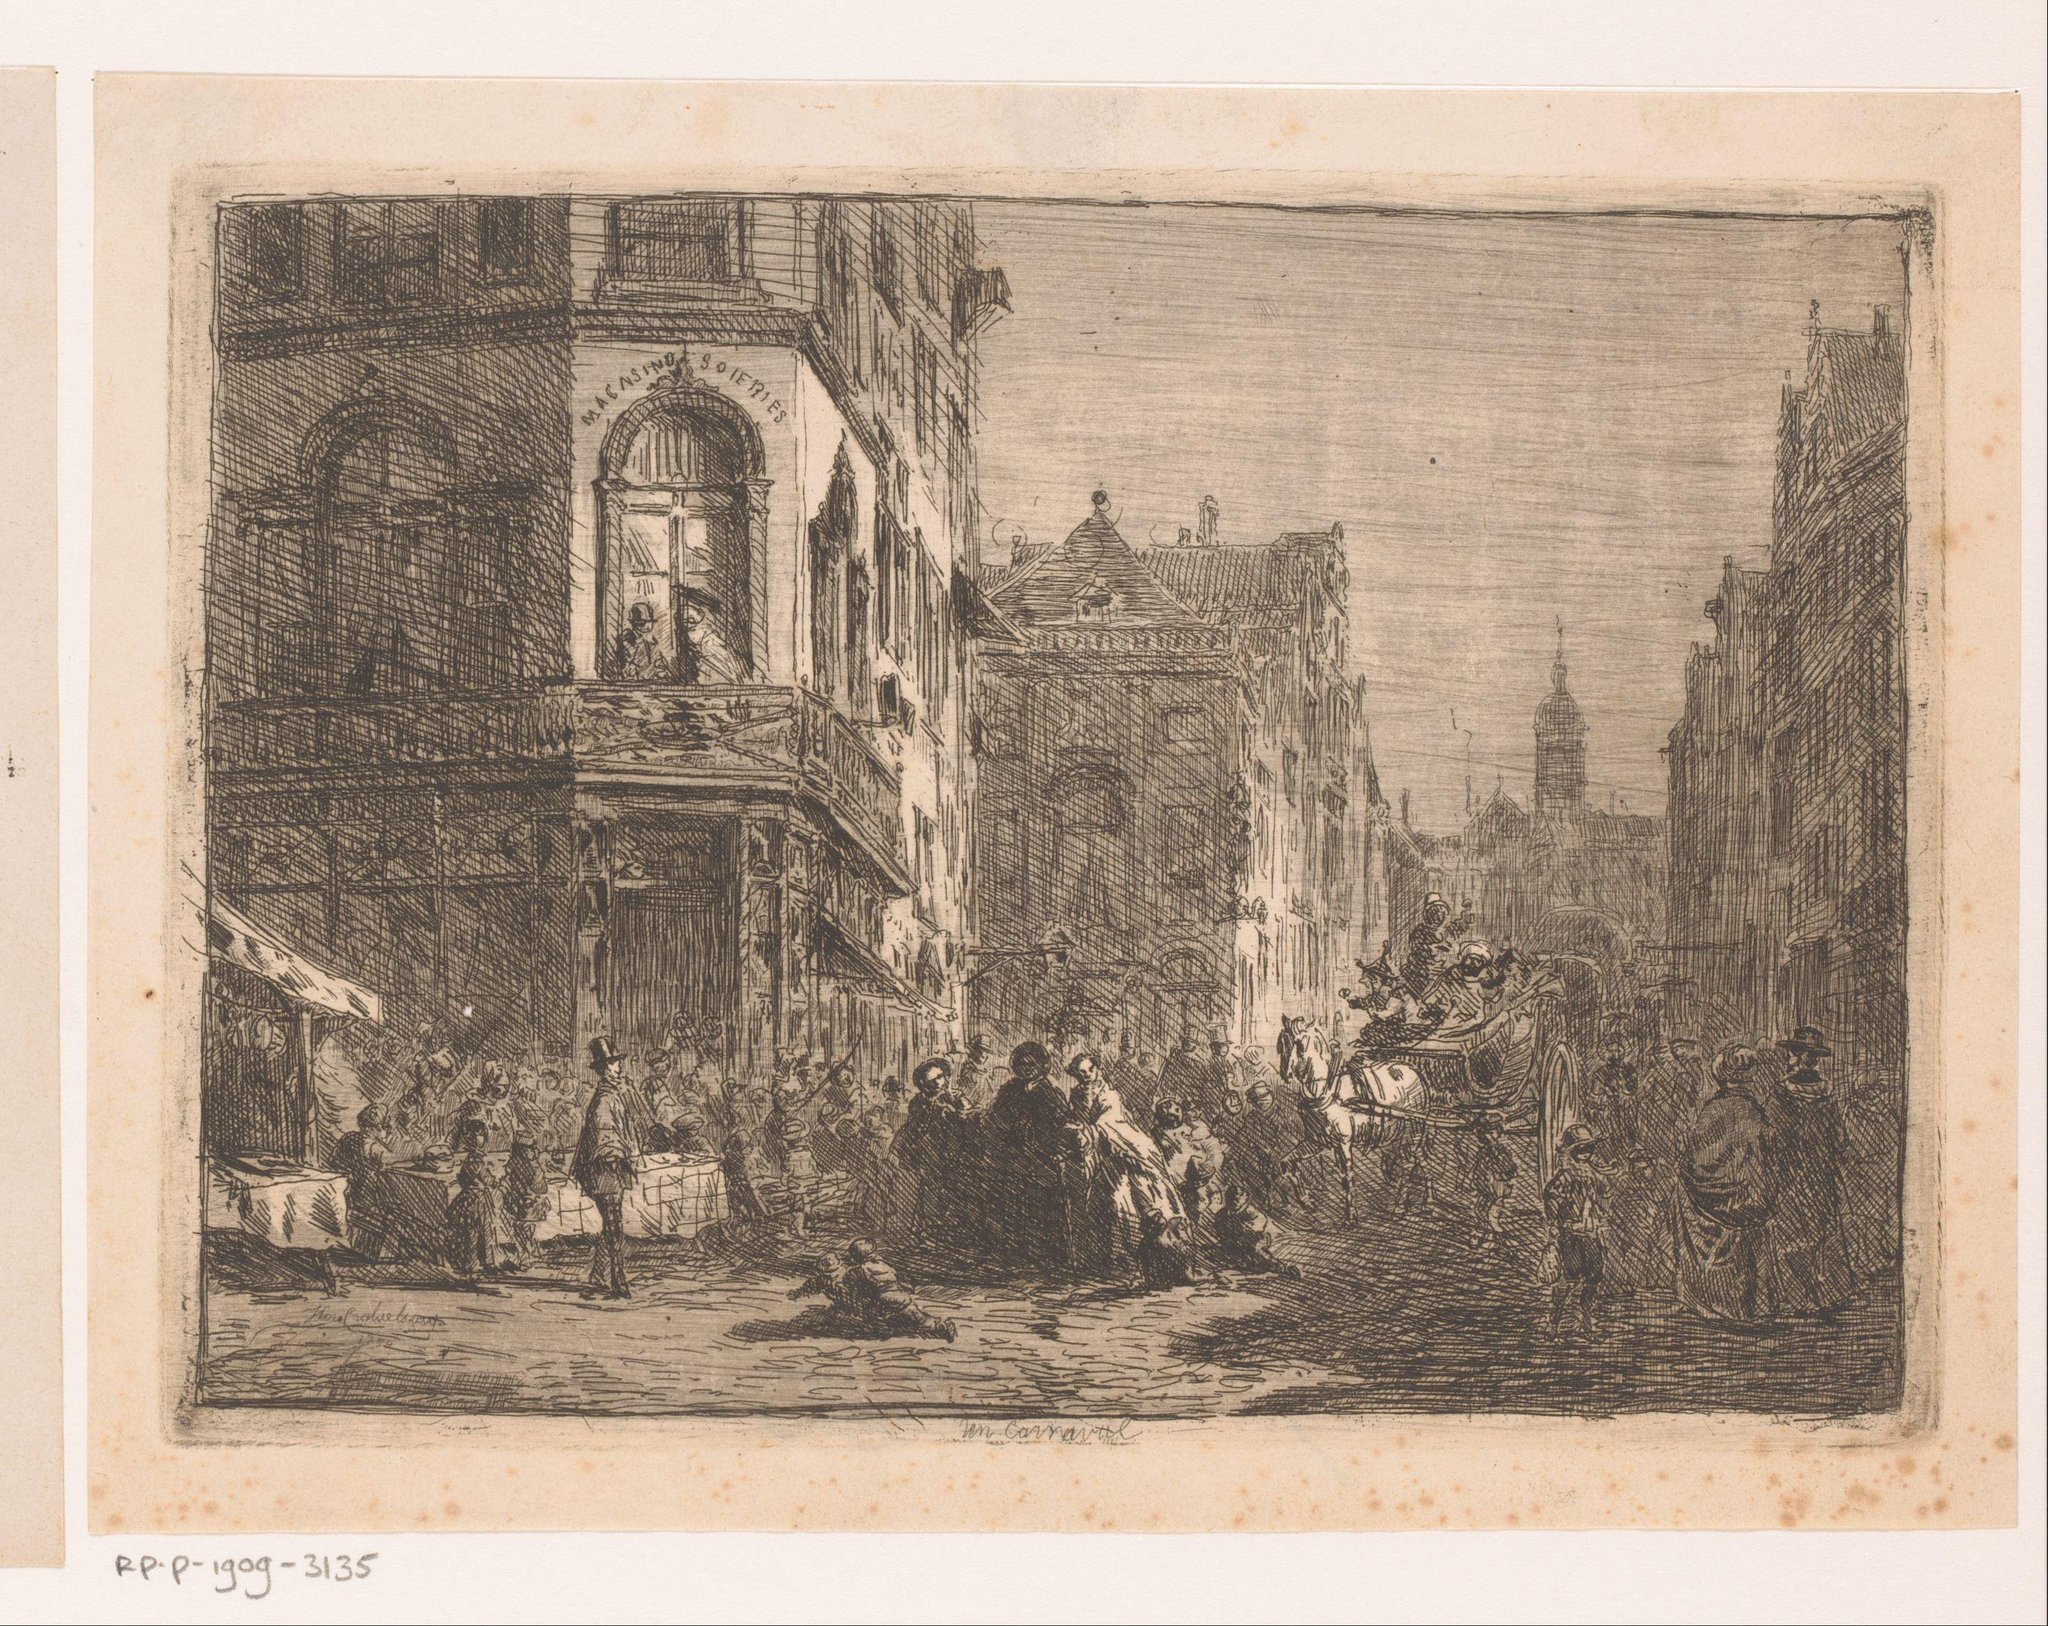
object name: print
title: Carnavalsoptocht door de stad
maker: florent nicolas crabeels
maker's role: print maker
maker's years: 1829-1896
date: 1754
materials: paper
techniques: etching, intaglio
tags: carnival, shrovetide (non-liturgical celebration)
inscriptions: collector's mark: Lugt 2228, collector's mark: Lugt 1485